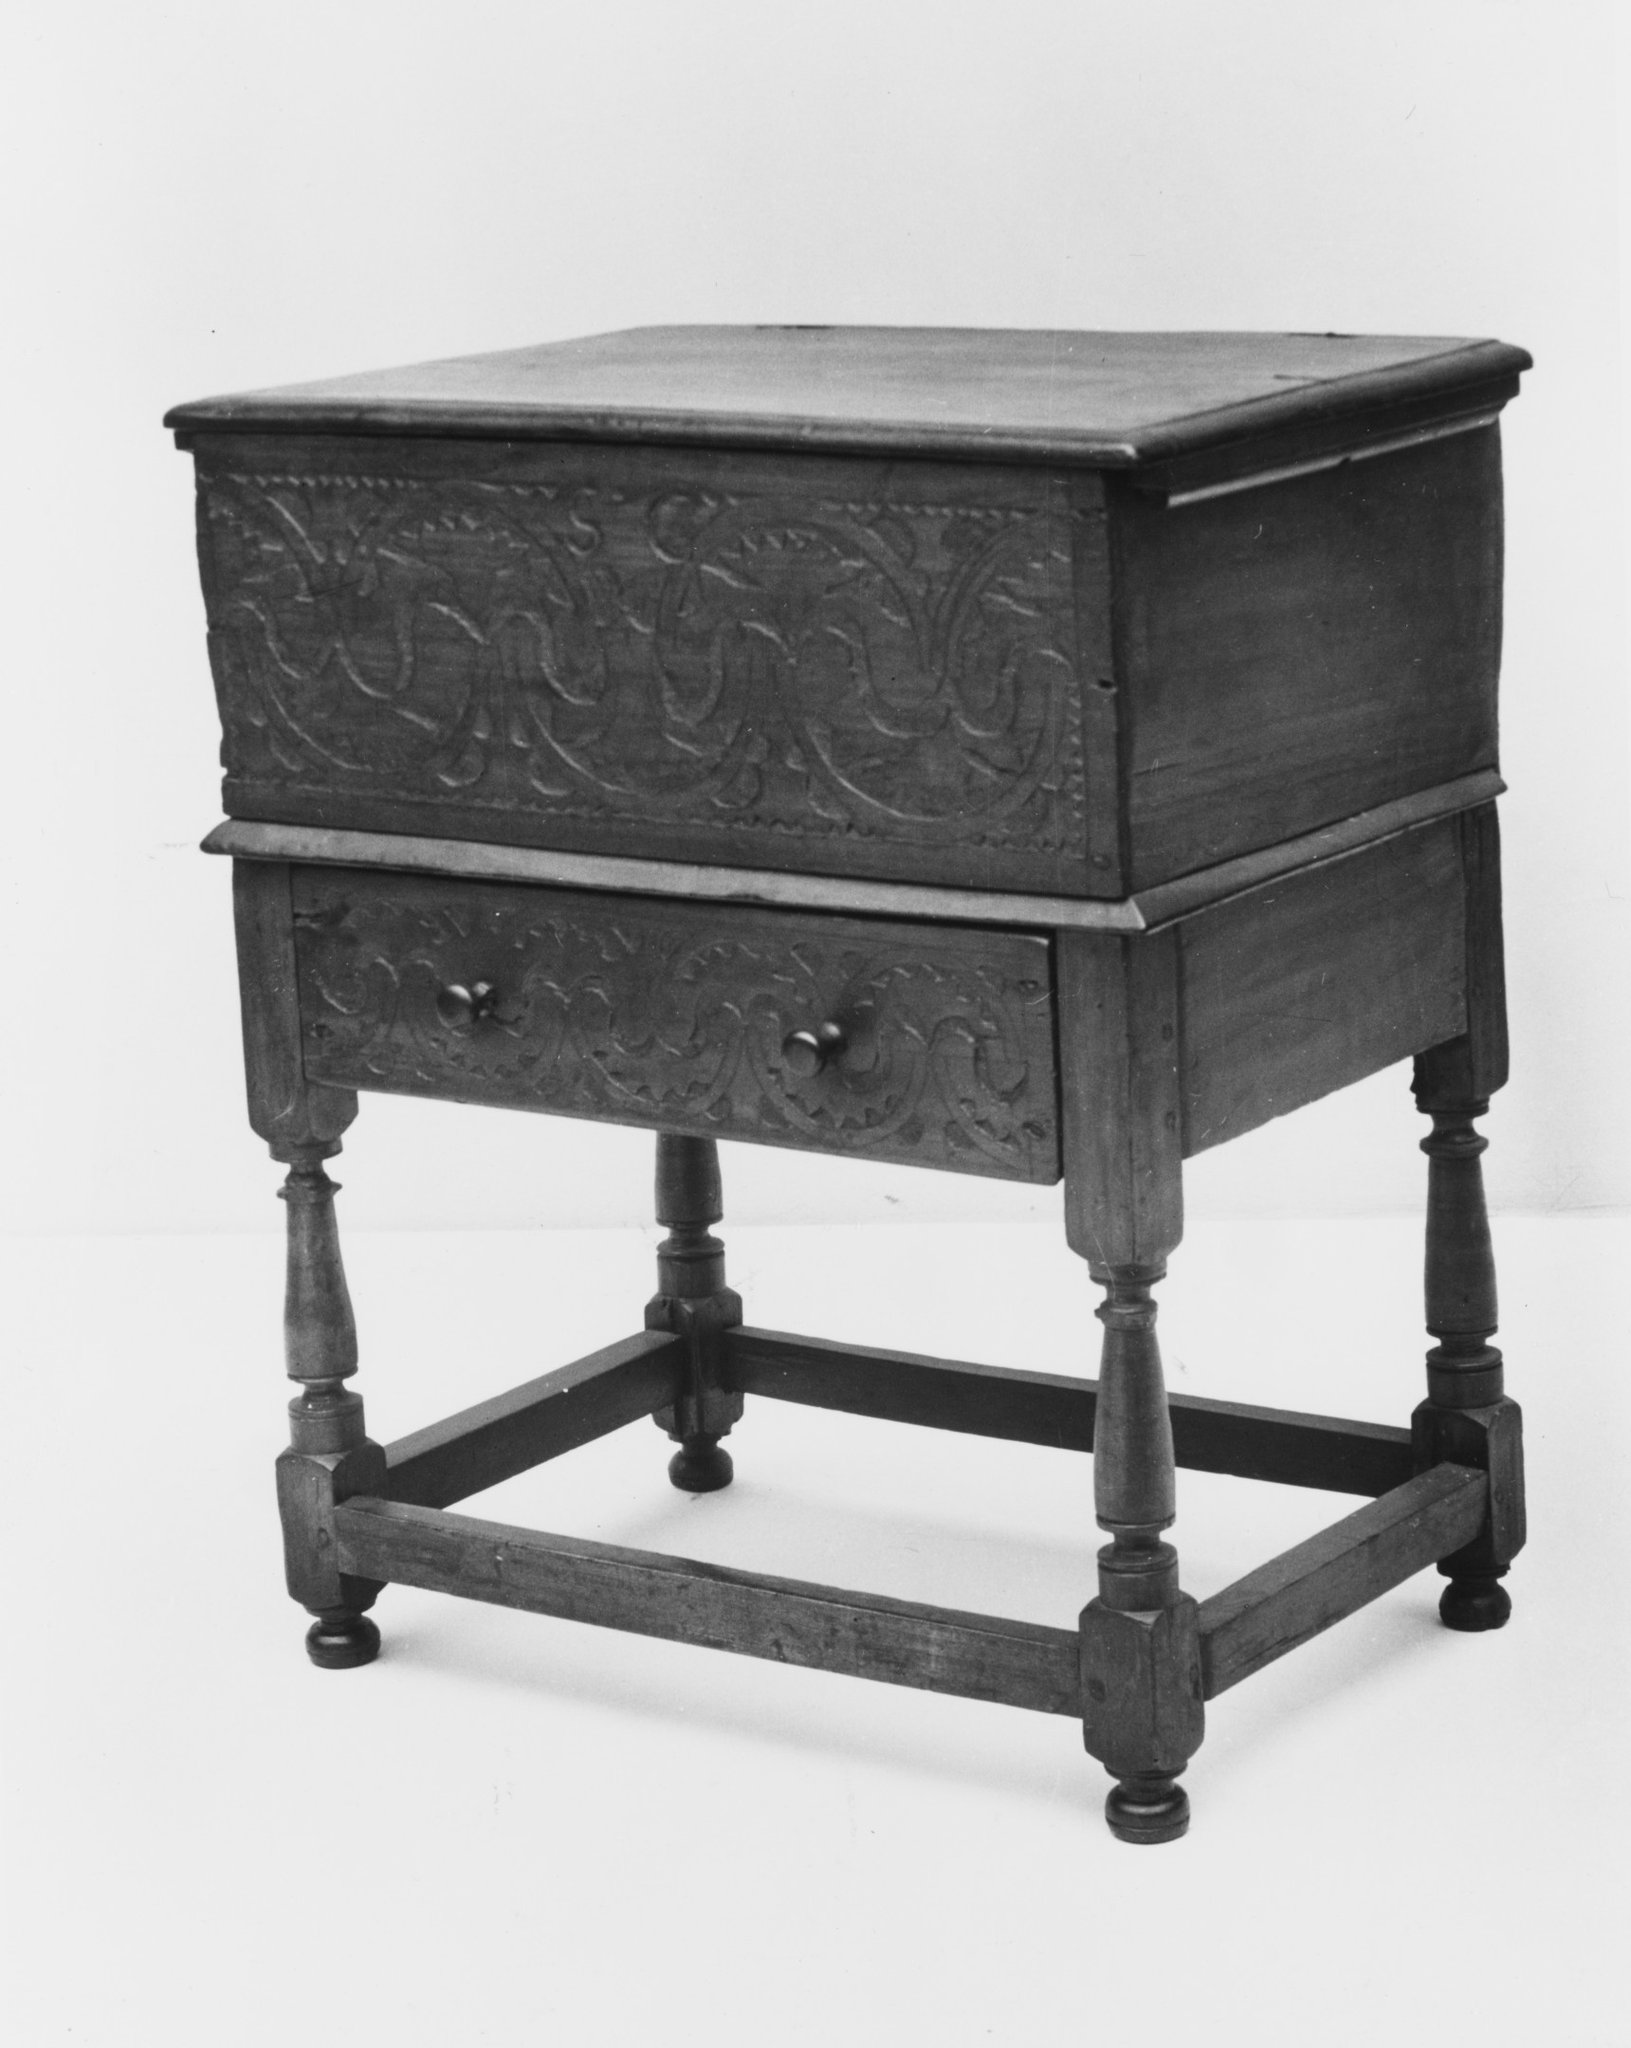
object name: desk on frame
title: Desk-on-frame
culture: american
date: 1670-1700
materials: wood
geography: united states